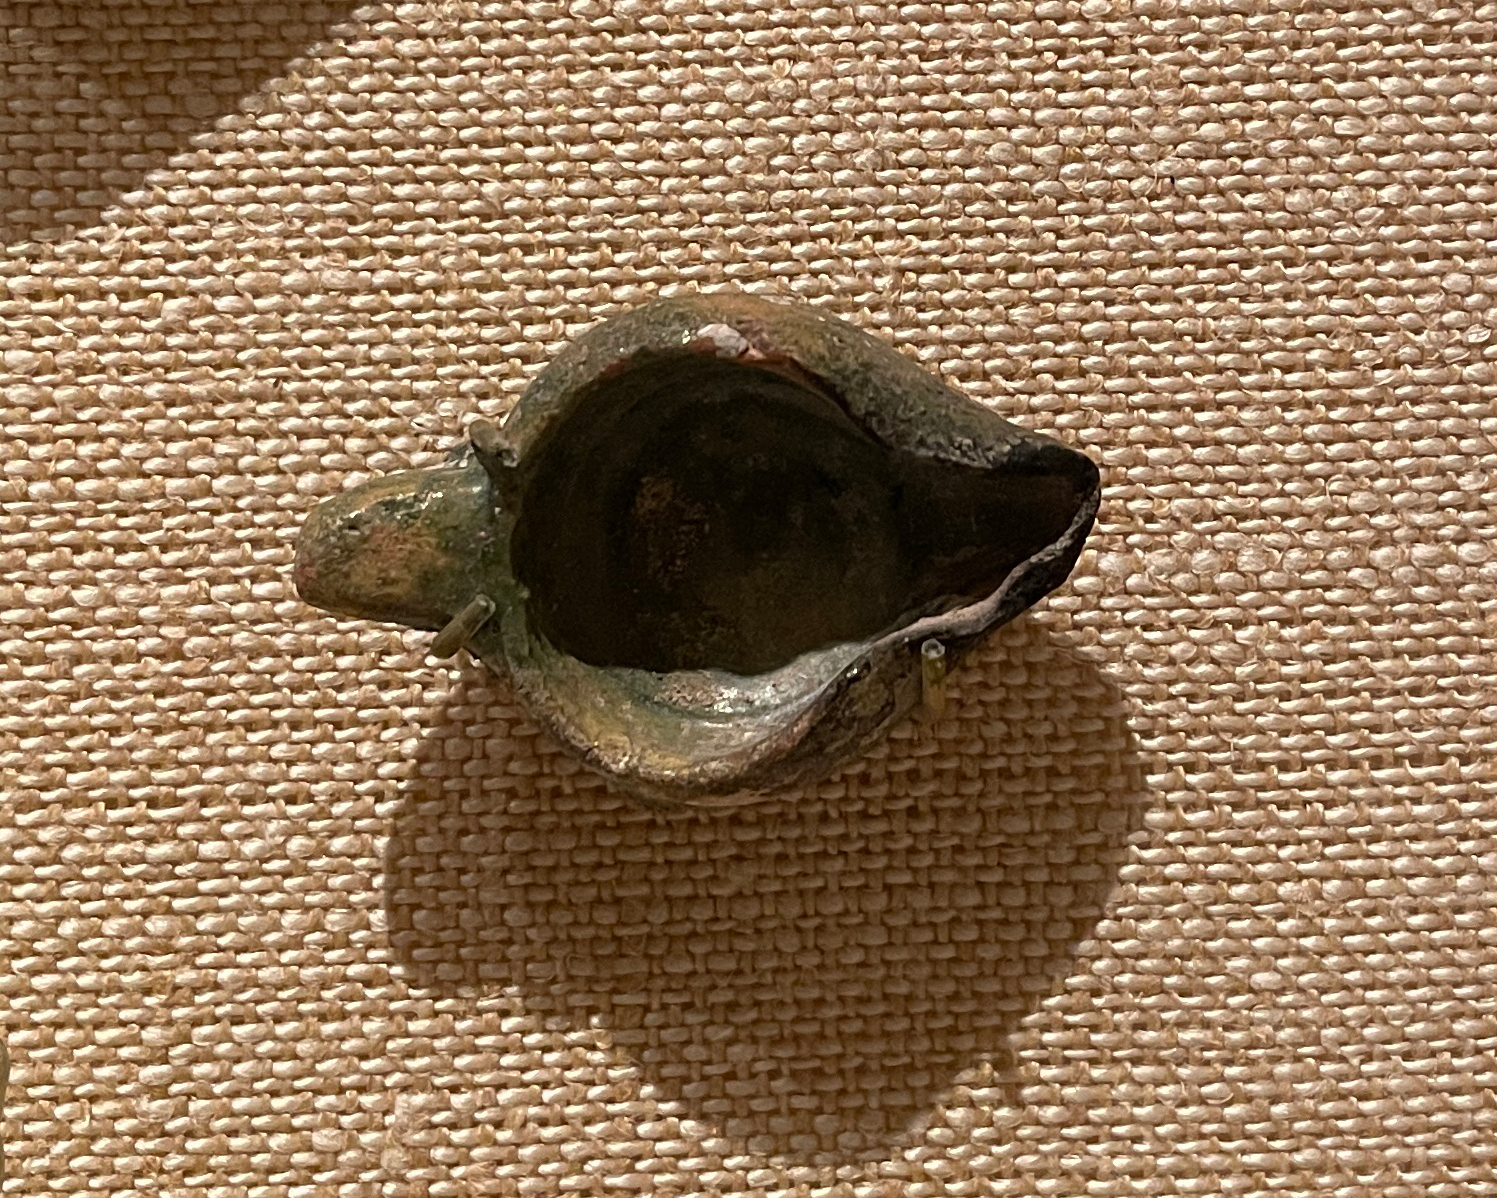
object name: lamp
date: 801-1100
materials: stonepaste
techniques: glazing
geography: iran